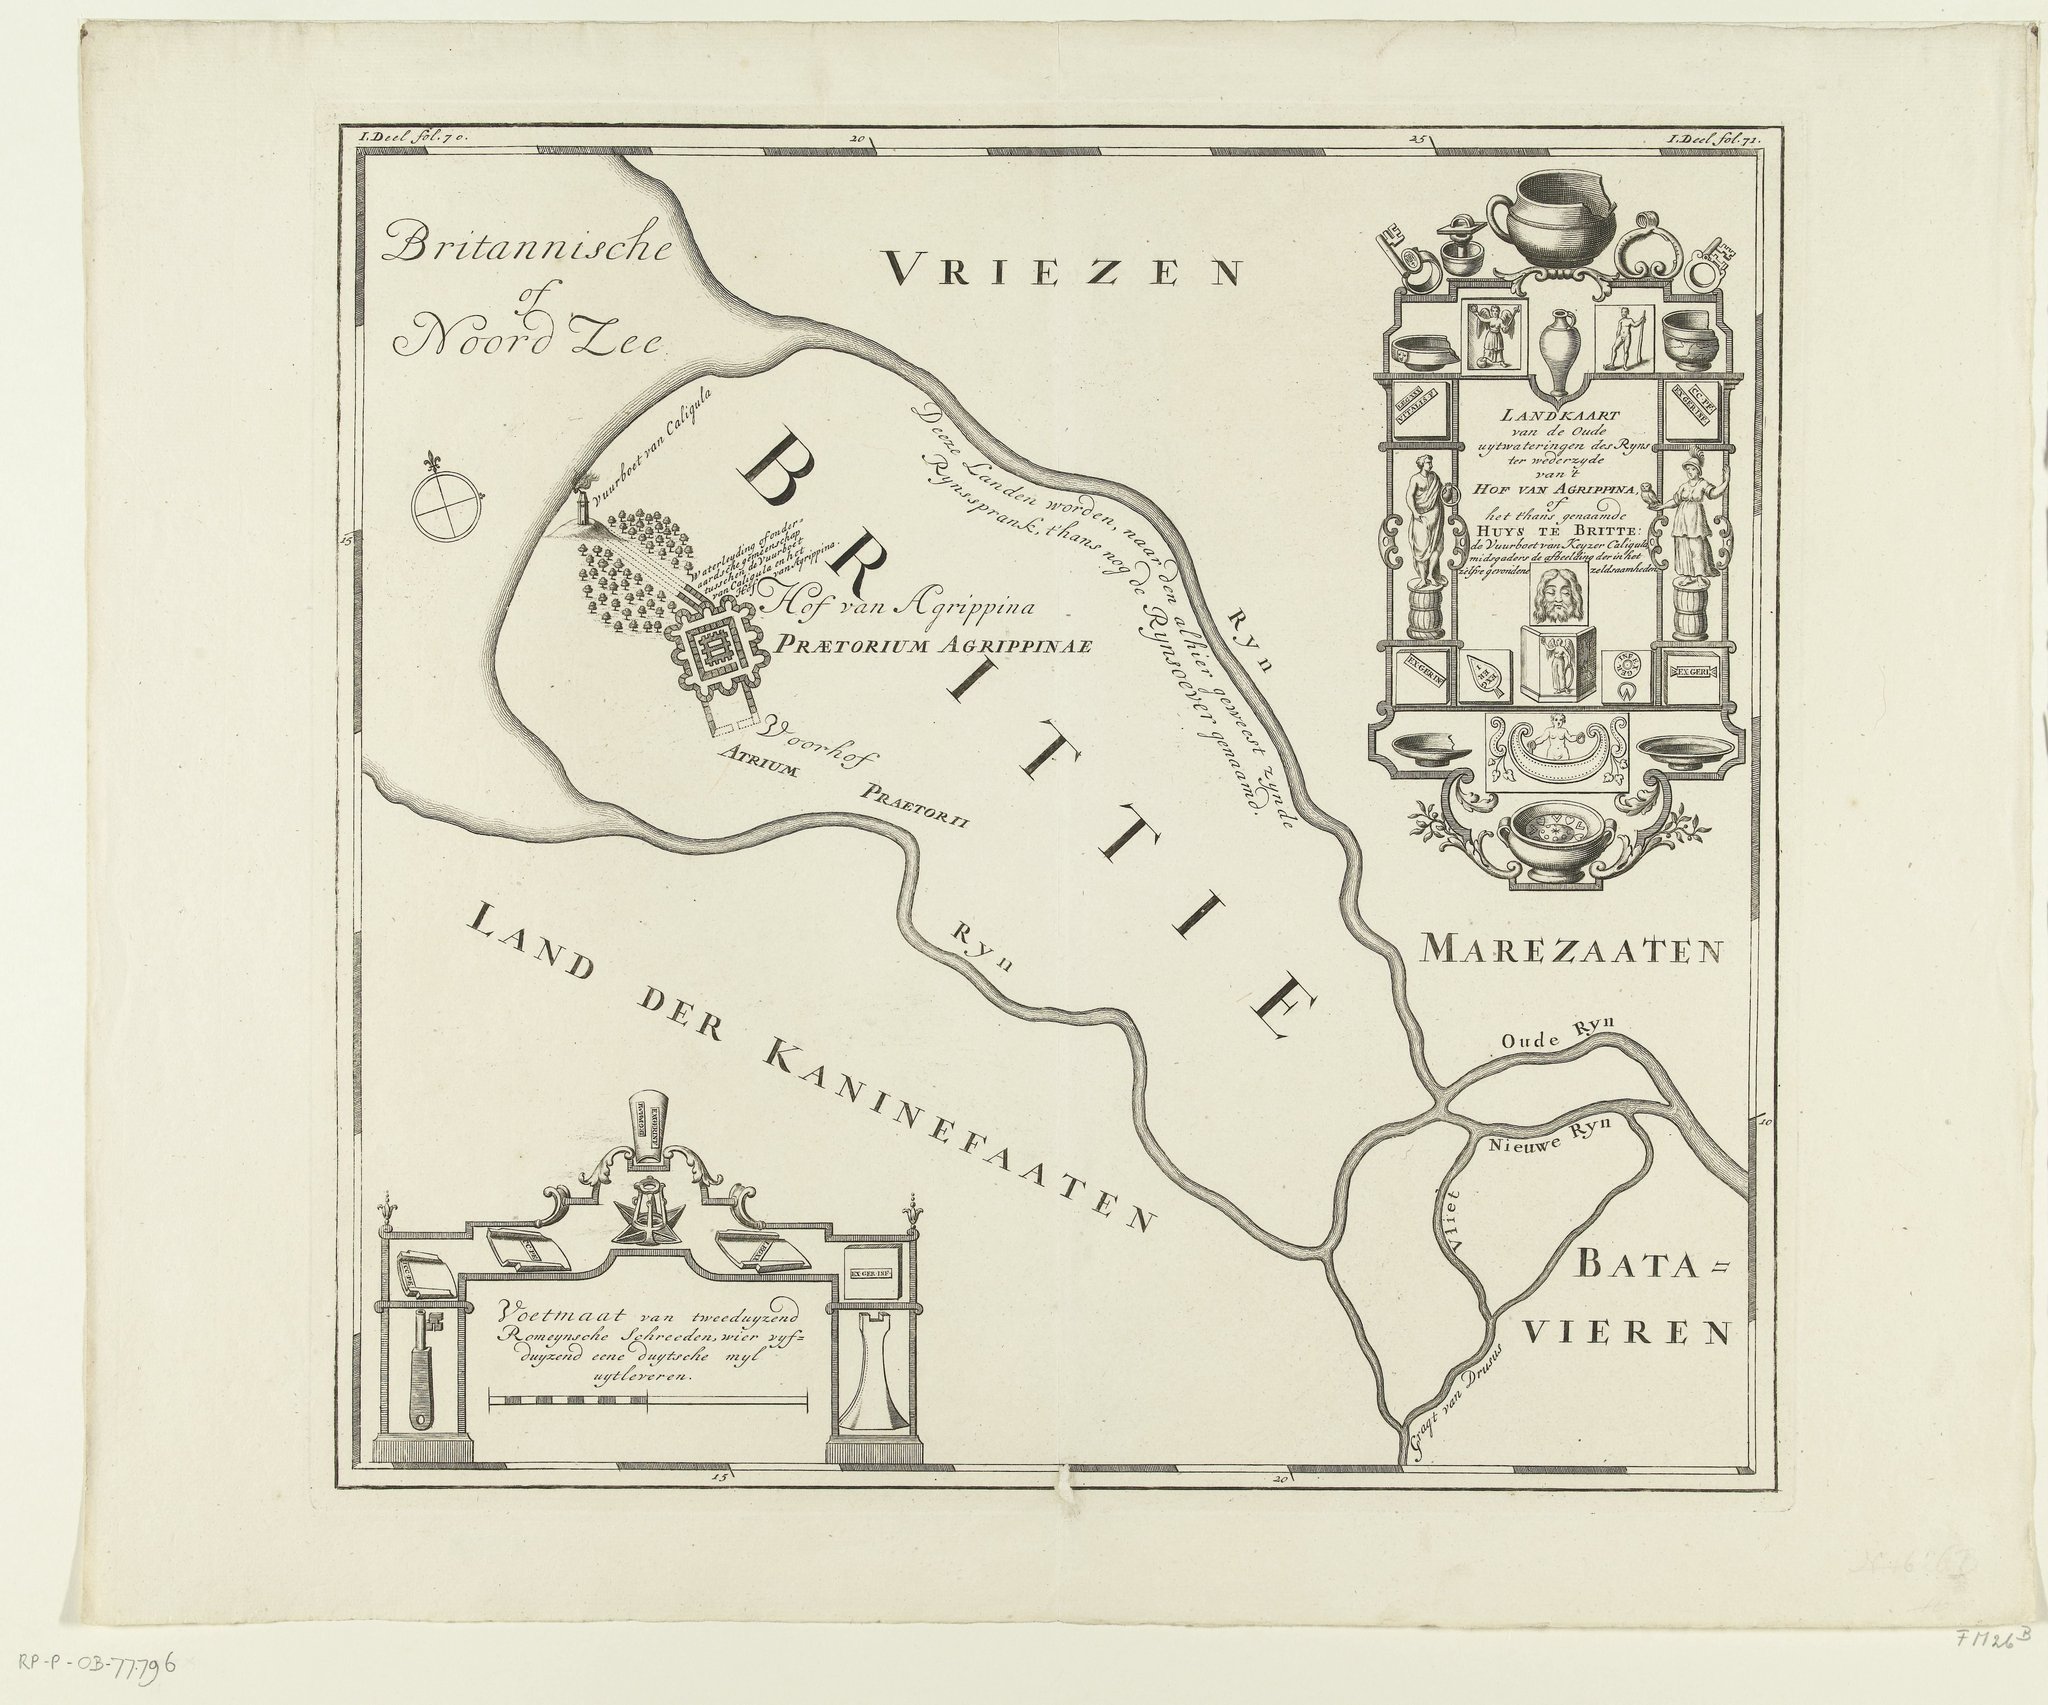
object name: print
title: De Brittenburg bij Katwijk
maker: Anonymous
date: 1732-1734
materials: paper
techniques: etching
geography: netherlands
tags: maps of separate countries or regions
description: Historische kaart van de monding van de Rijn en het Huis te Britten en de Vuurboet van Caligula bij Katwijk. Met cartouche waarin titel en gevonden oudheden. Maakt deel uit van de 8 kaarten in G. van Loon, Aloude Hollandsche Histori... sedert de komst der Batavieren in... Holland, 2 delen, bij Pieter de Hond, 's-Gravenhage 1734. Volgens opschrift geplaatst in: Deel I, fol. 70/71.